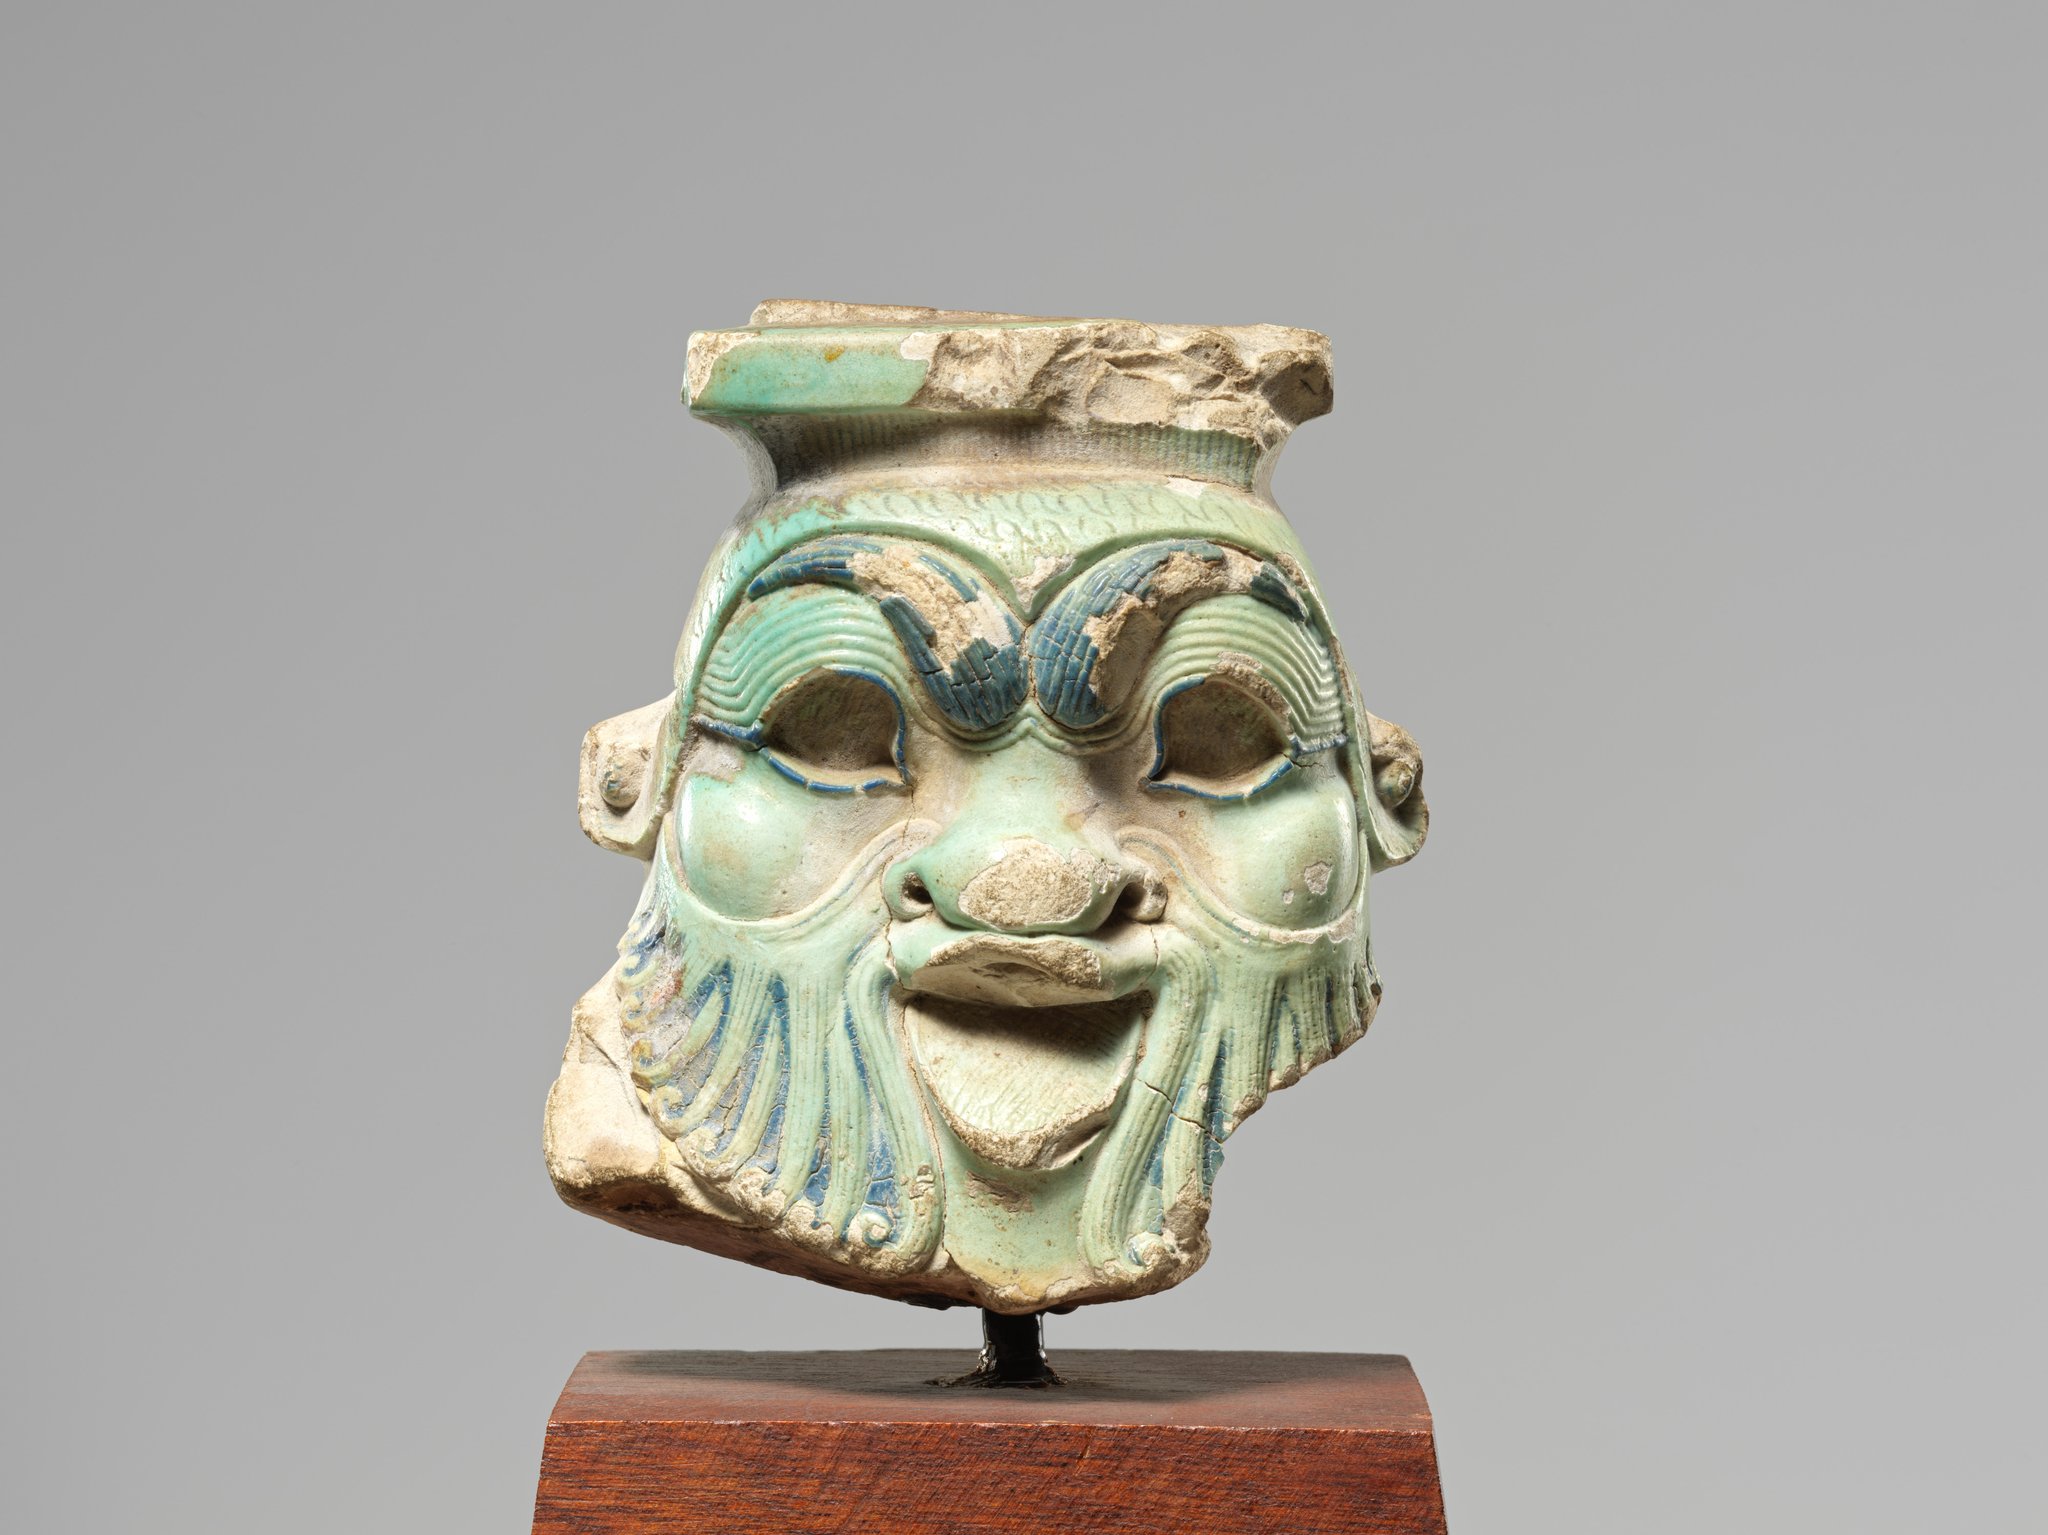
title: Head from a Bes Jar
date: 664-630 BCE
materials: faience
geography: egypt